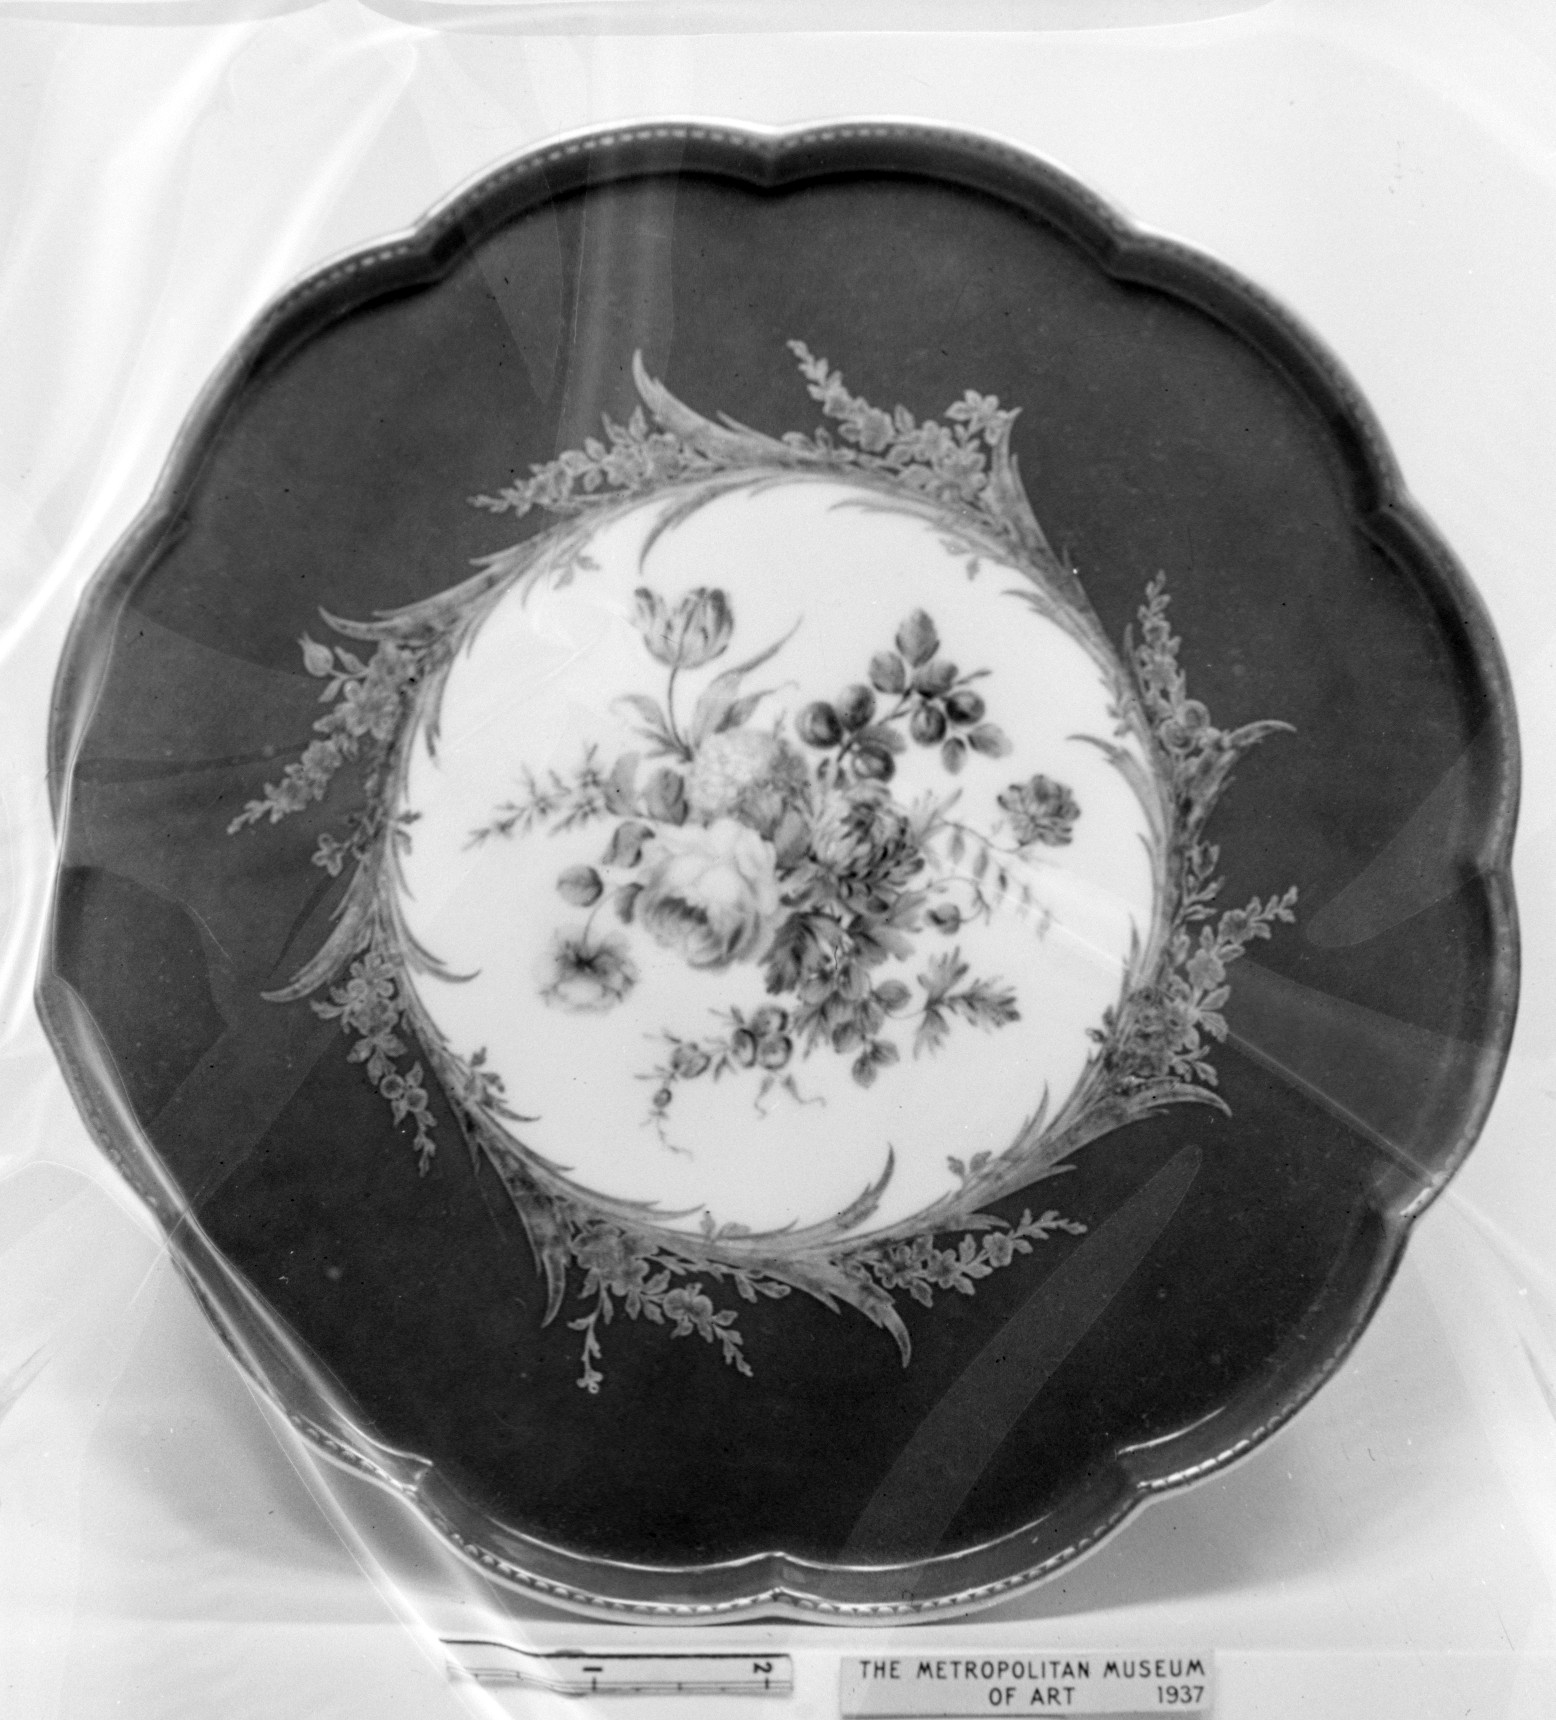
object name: tray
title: Tray (Soucoupe à pied) (one of four) (part of a service)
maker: sèvres manufactory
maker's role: manufactory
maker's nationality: french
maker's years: 1740-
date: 1780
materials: hard paste porcelain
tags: fruit,flowers